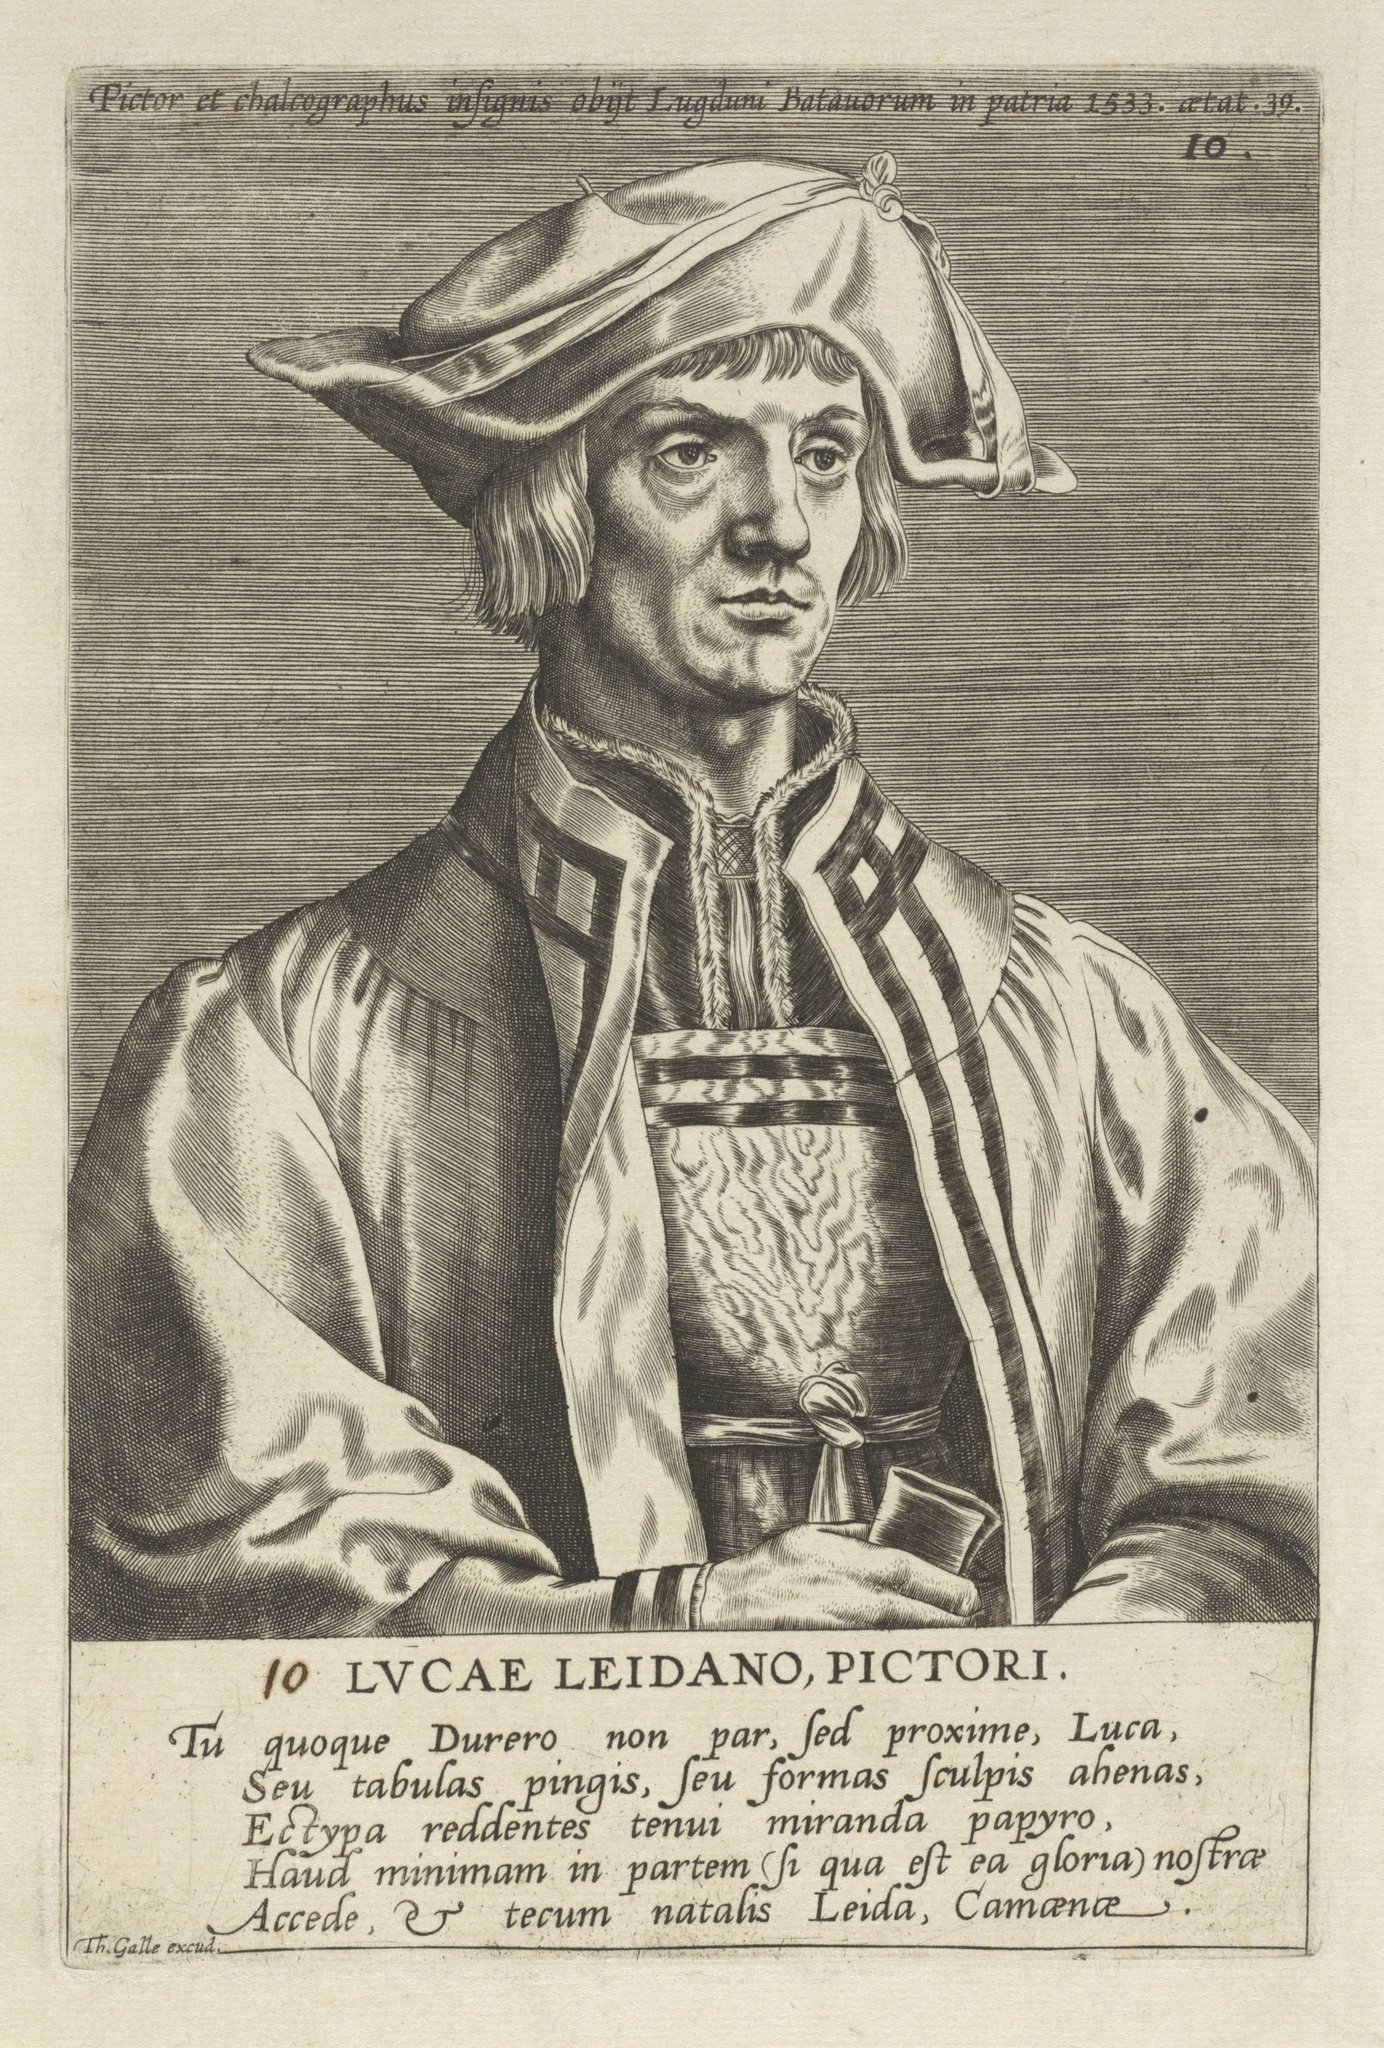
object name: print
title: Illustrium quos Belgium habuit pictorum Effigies ad vivum accurate delineatae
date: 1600-1650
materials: paper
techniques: engraving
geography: antwerp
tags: leiden, painter, print maker, draughtsman, lucas van leyden, portrait, self-portrait of painter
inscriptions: collector's mark: Lugt 2228, number: ‘10’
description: Boven de geportretteerde een regel met biografische gegevens in het Latijn. In de marge een vijfregelig onderschrift in het Latijn.